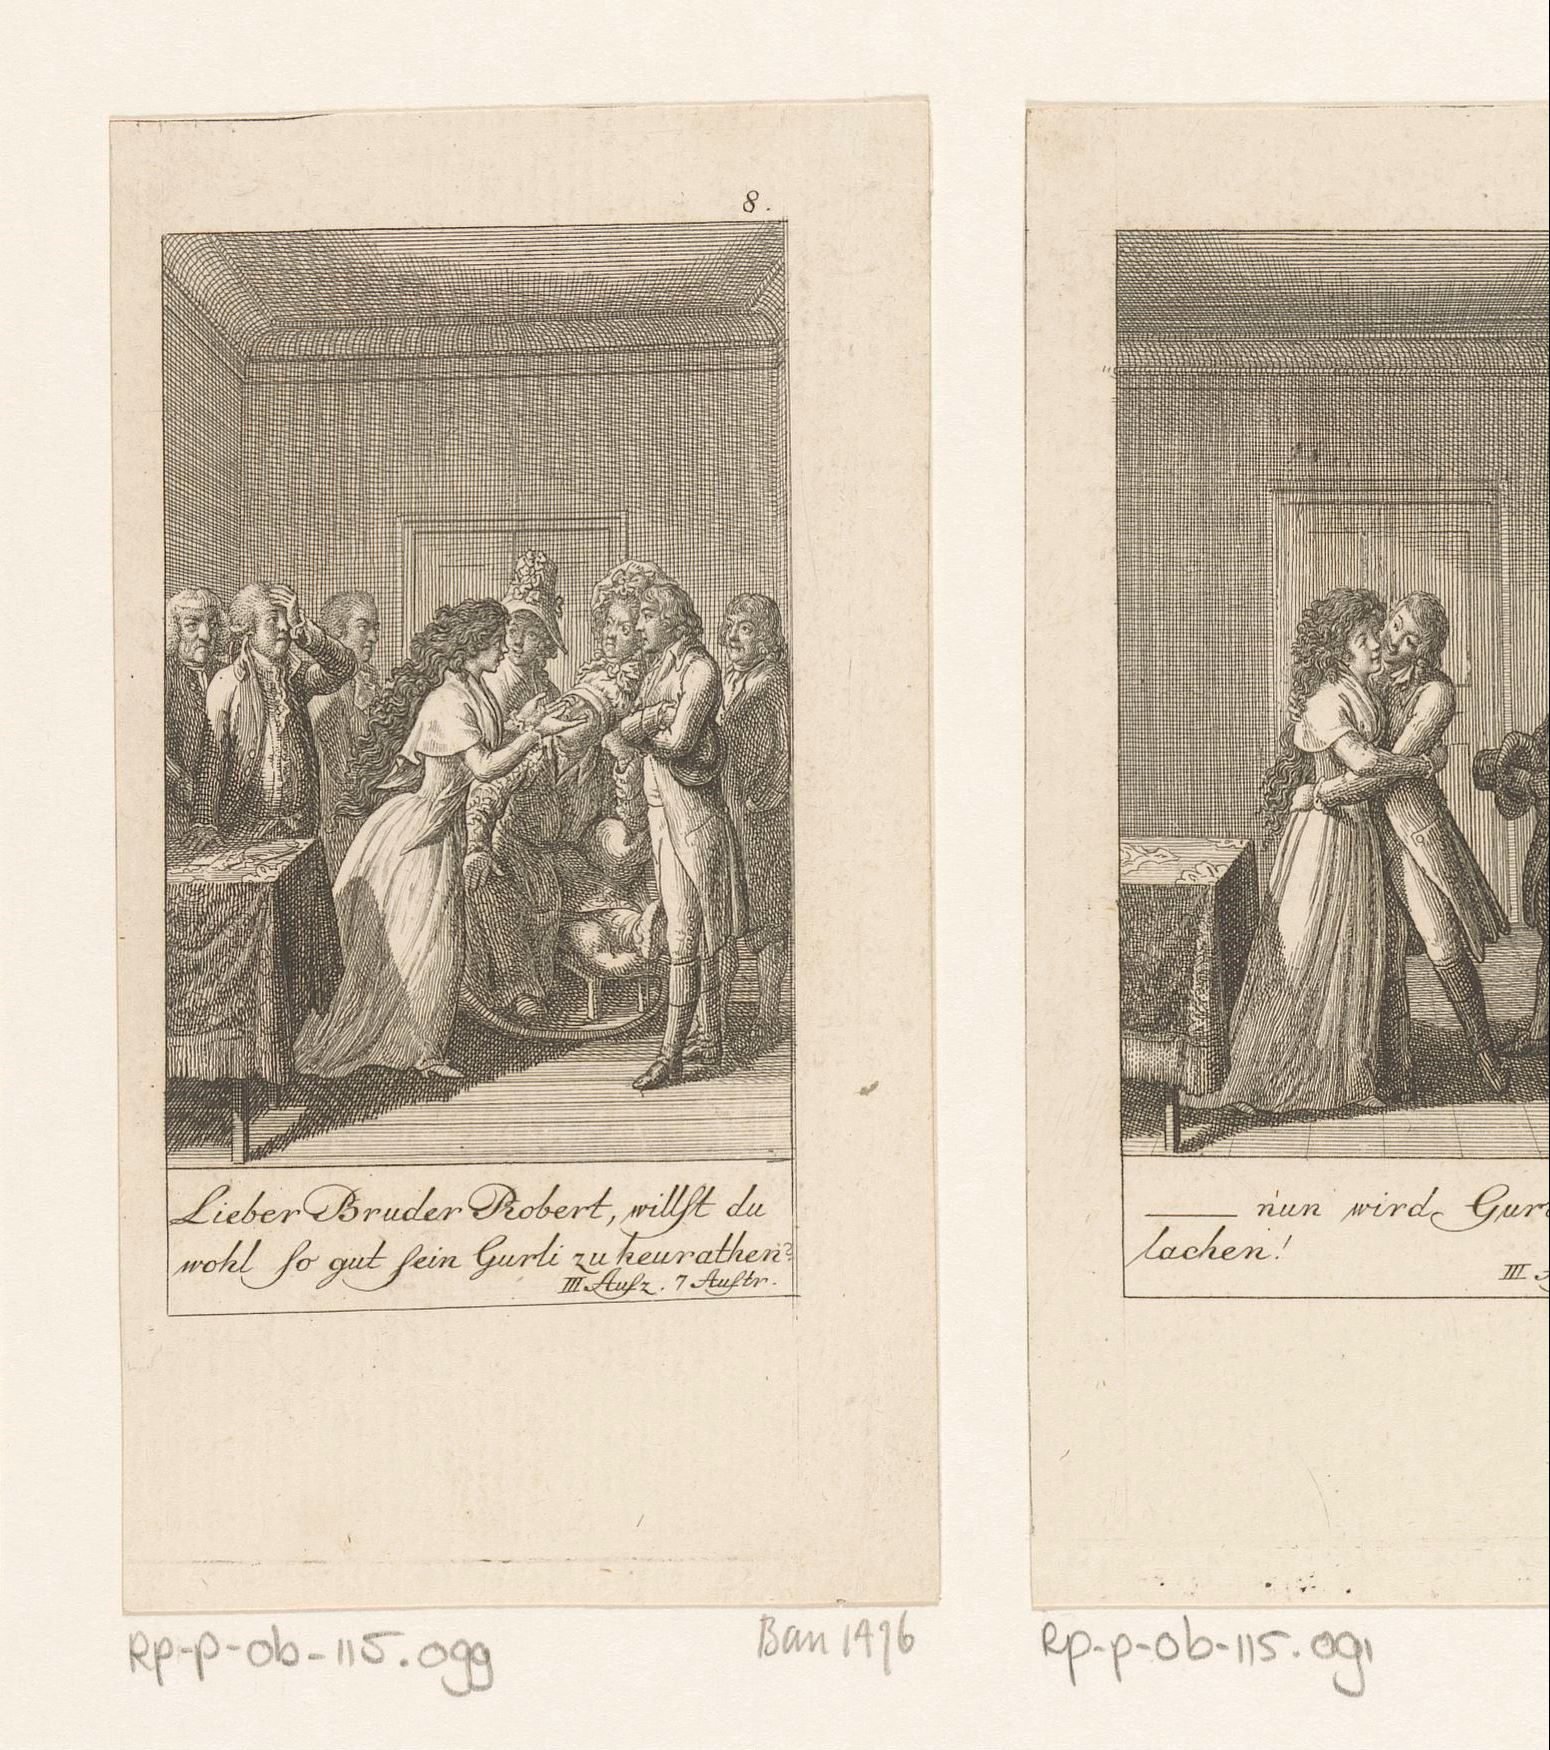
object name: book illustration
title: Gurli ontkomt aan haar schijnhuwelijk en vraagt Robert met haar te trouwen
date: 1790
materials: paper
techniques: etching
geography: berlin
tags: literature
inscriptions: collector's mark: Lugt 2228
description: Vervaardigd voor 'De Indianen in Engeland' van August von Kotzebue. Prent gebruikt in: Königl. Grosbritannischer Historischer Genealogischer Calender für 1791. Lauenburg: Berenberg, [1790].